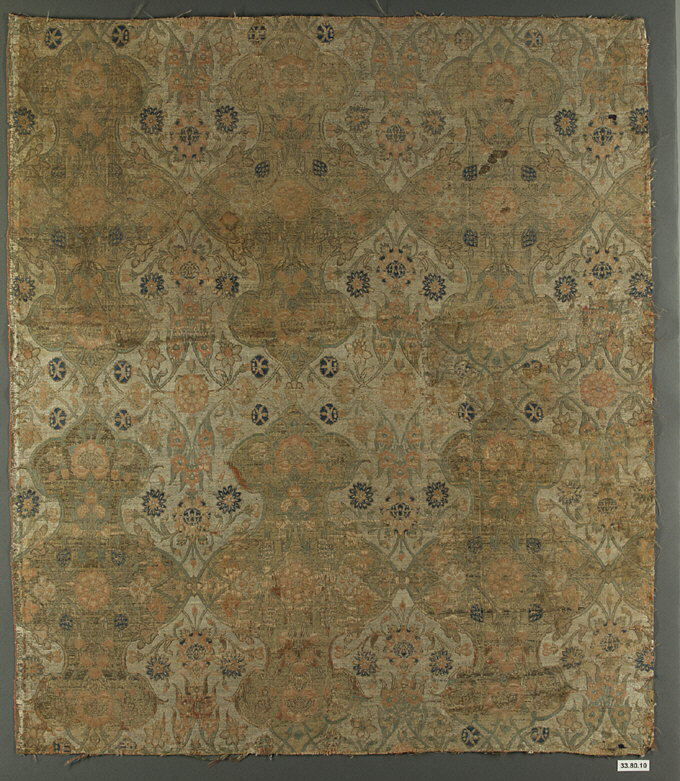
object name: cover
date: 1601-1650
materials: metal thread, silk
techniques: lampas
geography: iran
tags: flowers